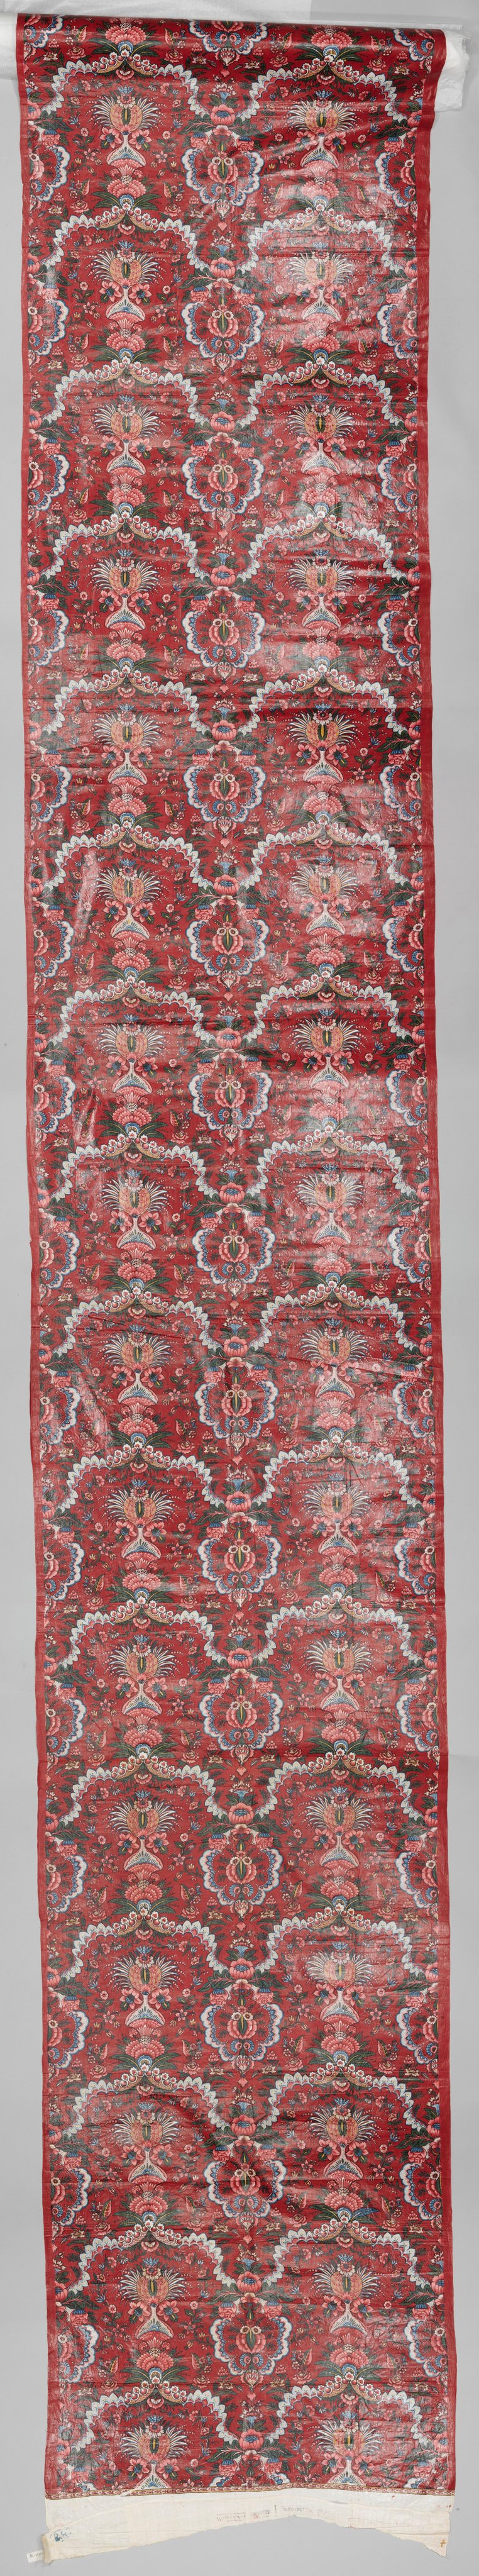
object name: textile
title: Bedrukt textiel met kantpatroon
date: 1725-1750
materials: cotton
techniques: printing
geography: alsace